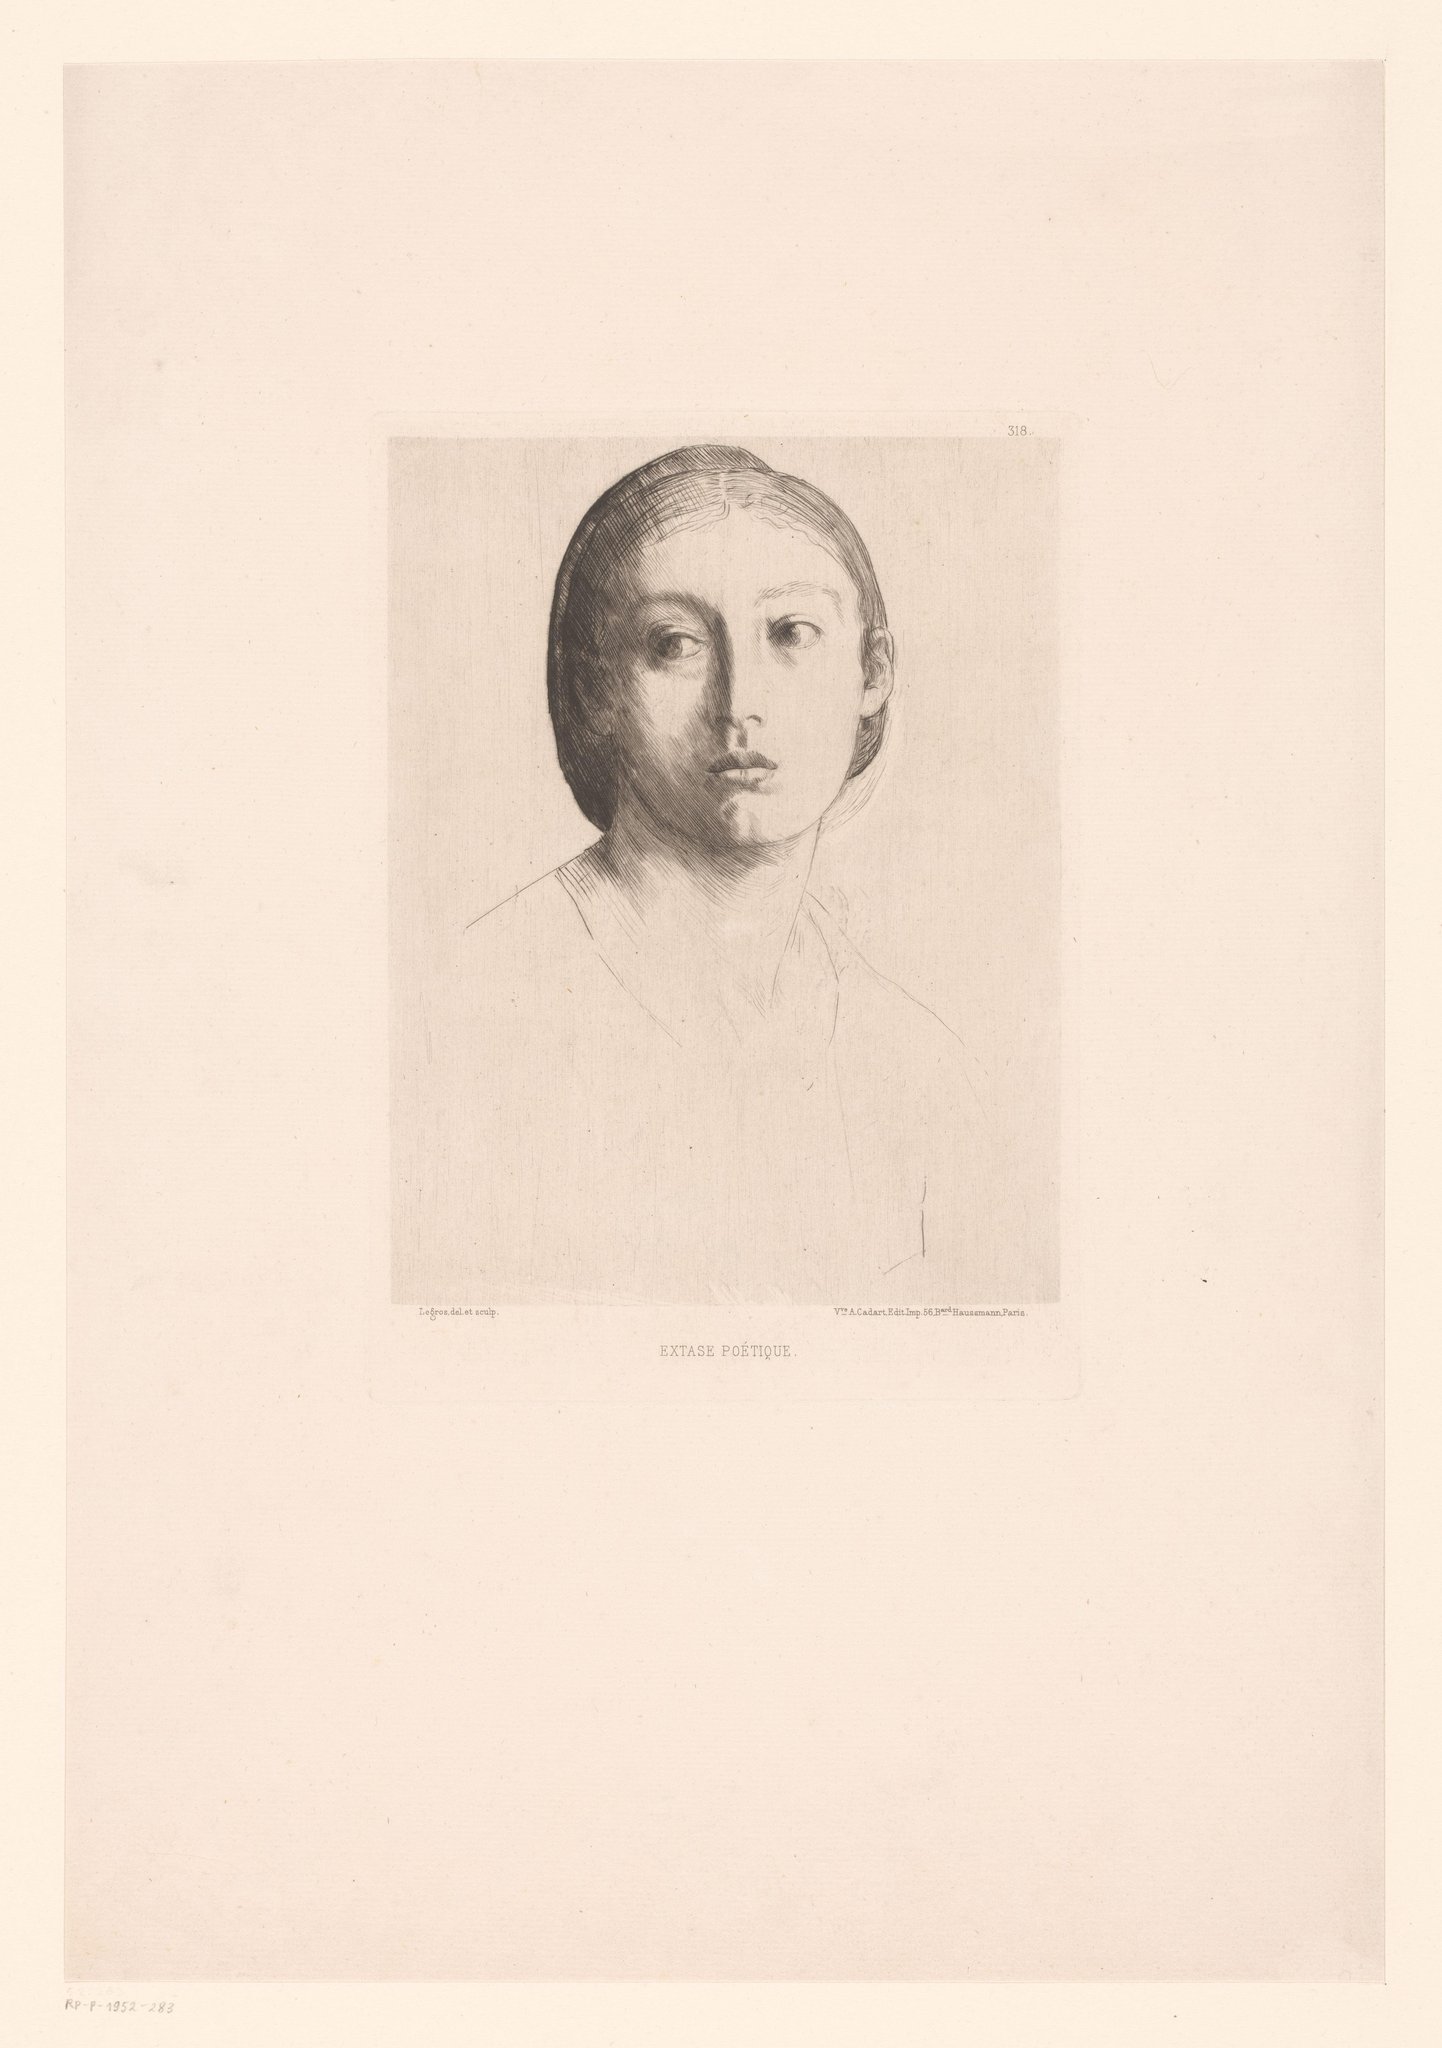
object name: print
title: Extase poétique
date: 1876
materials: paper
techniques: drypoint, engraving, etching, intaglio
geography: paris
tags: adult woman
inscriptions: collector's mark: Lugt 2228